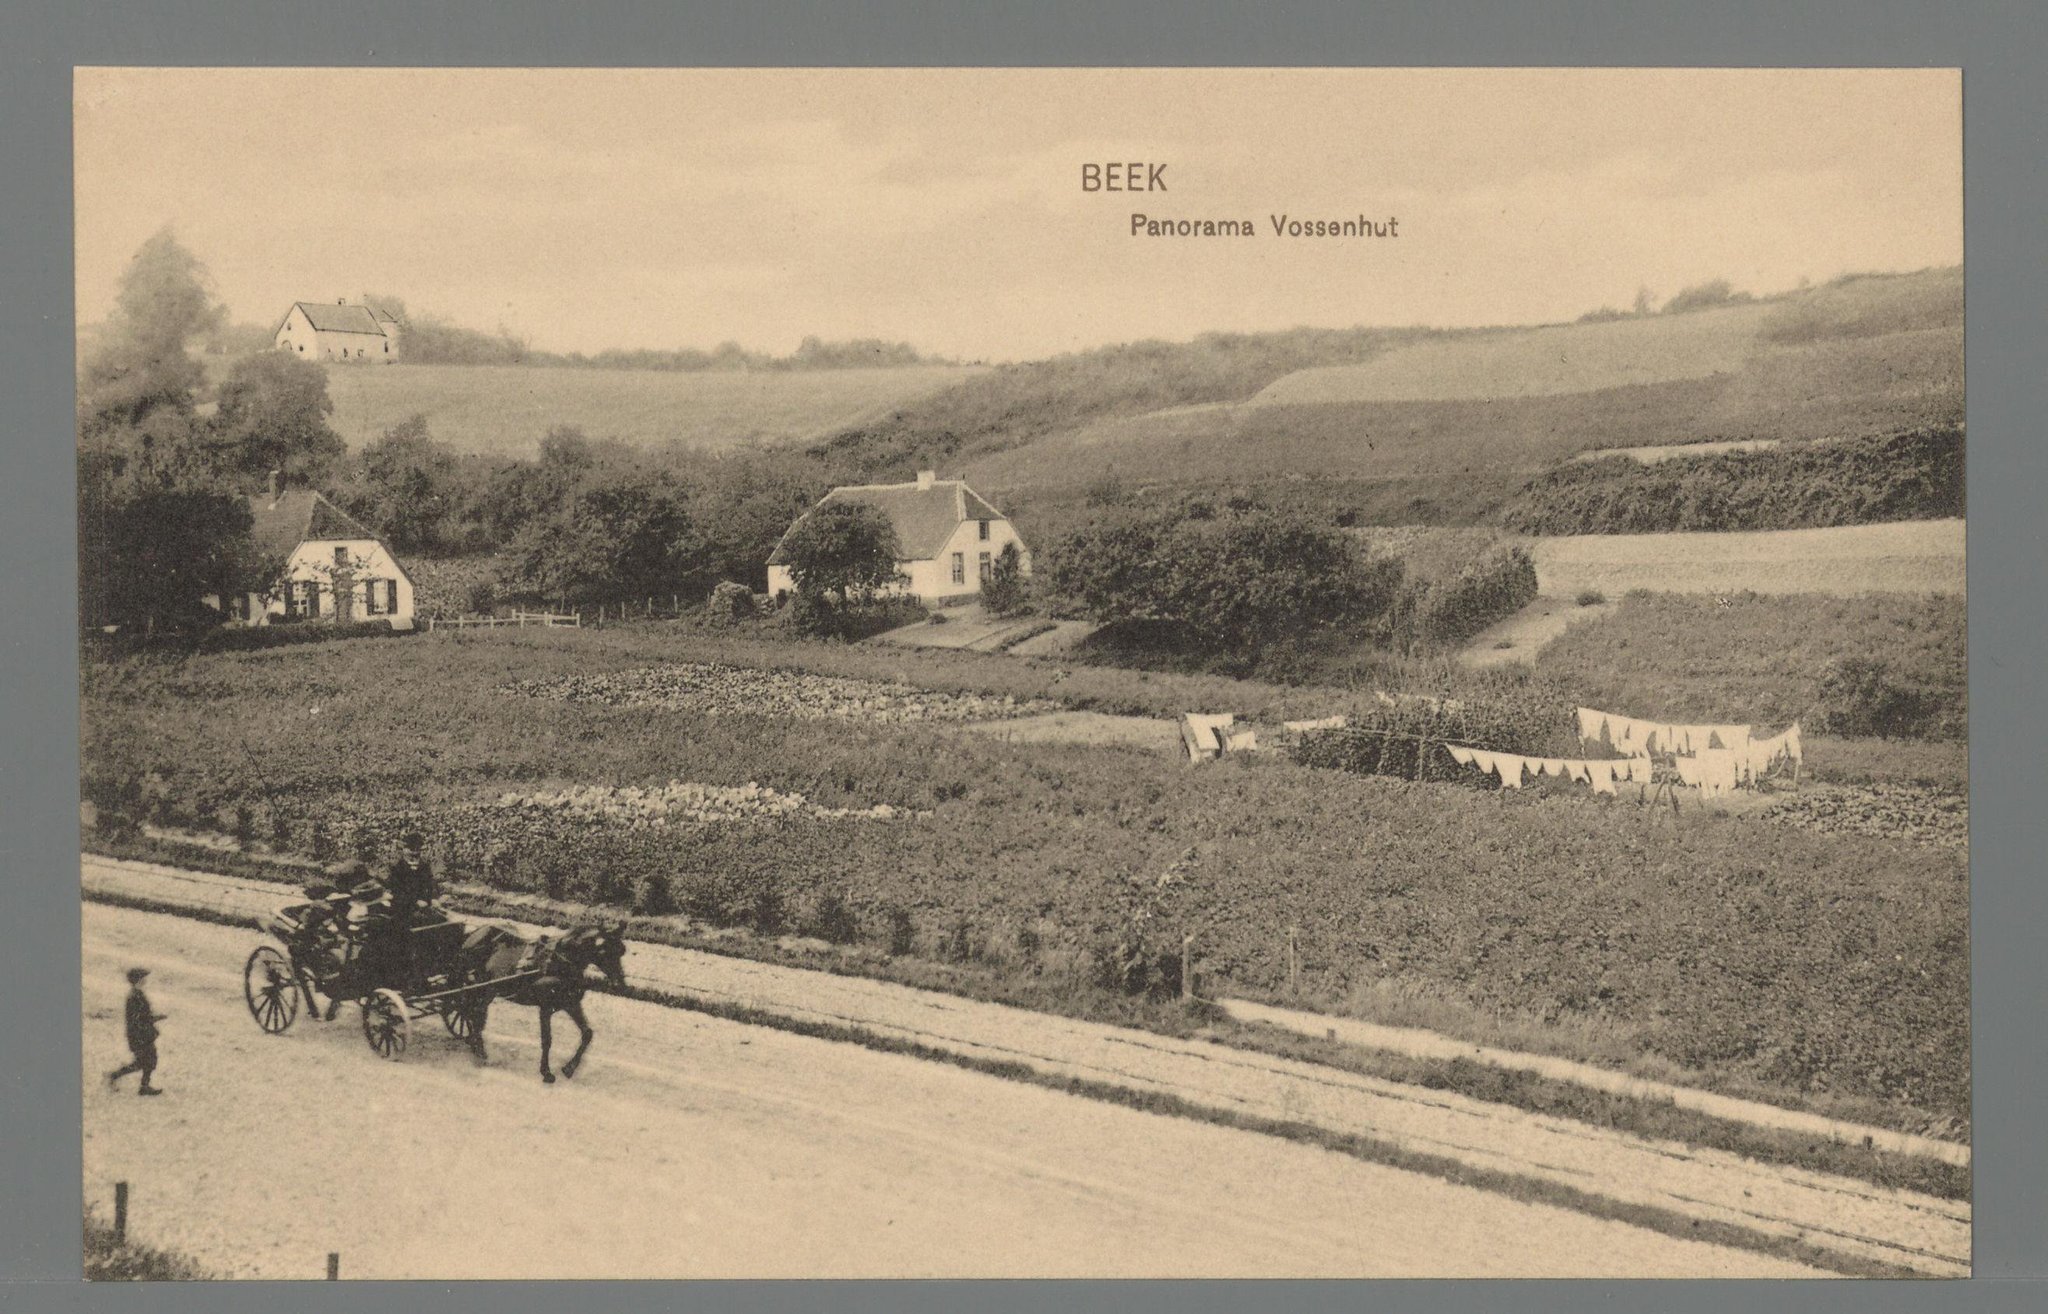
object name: photomechanical print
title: Beek. Panorama Vossenhut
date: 1913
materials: cardboard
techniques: photograph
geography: nijmegen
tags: dale, valley, prospect of city, town panorama, silhouette of city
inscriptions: date